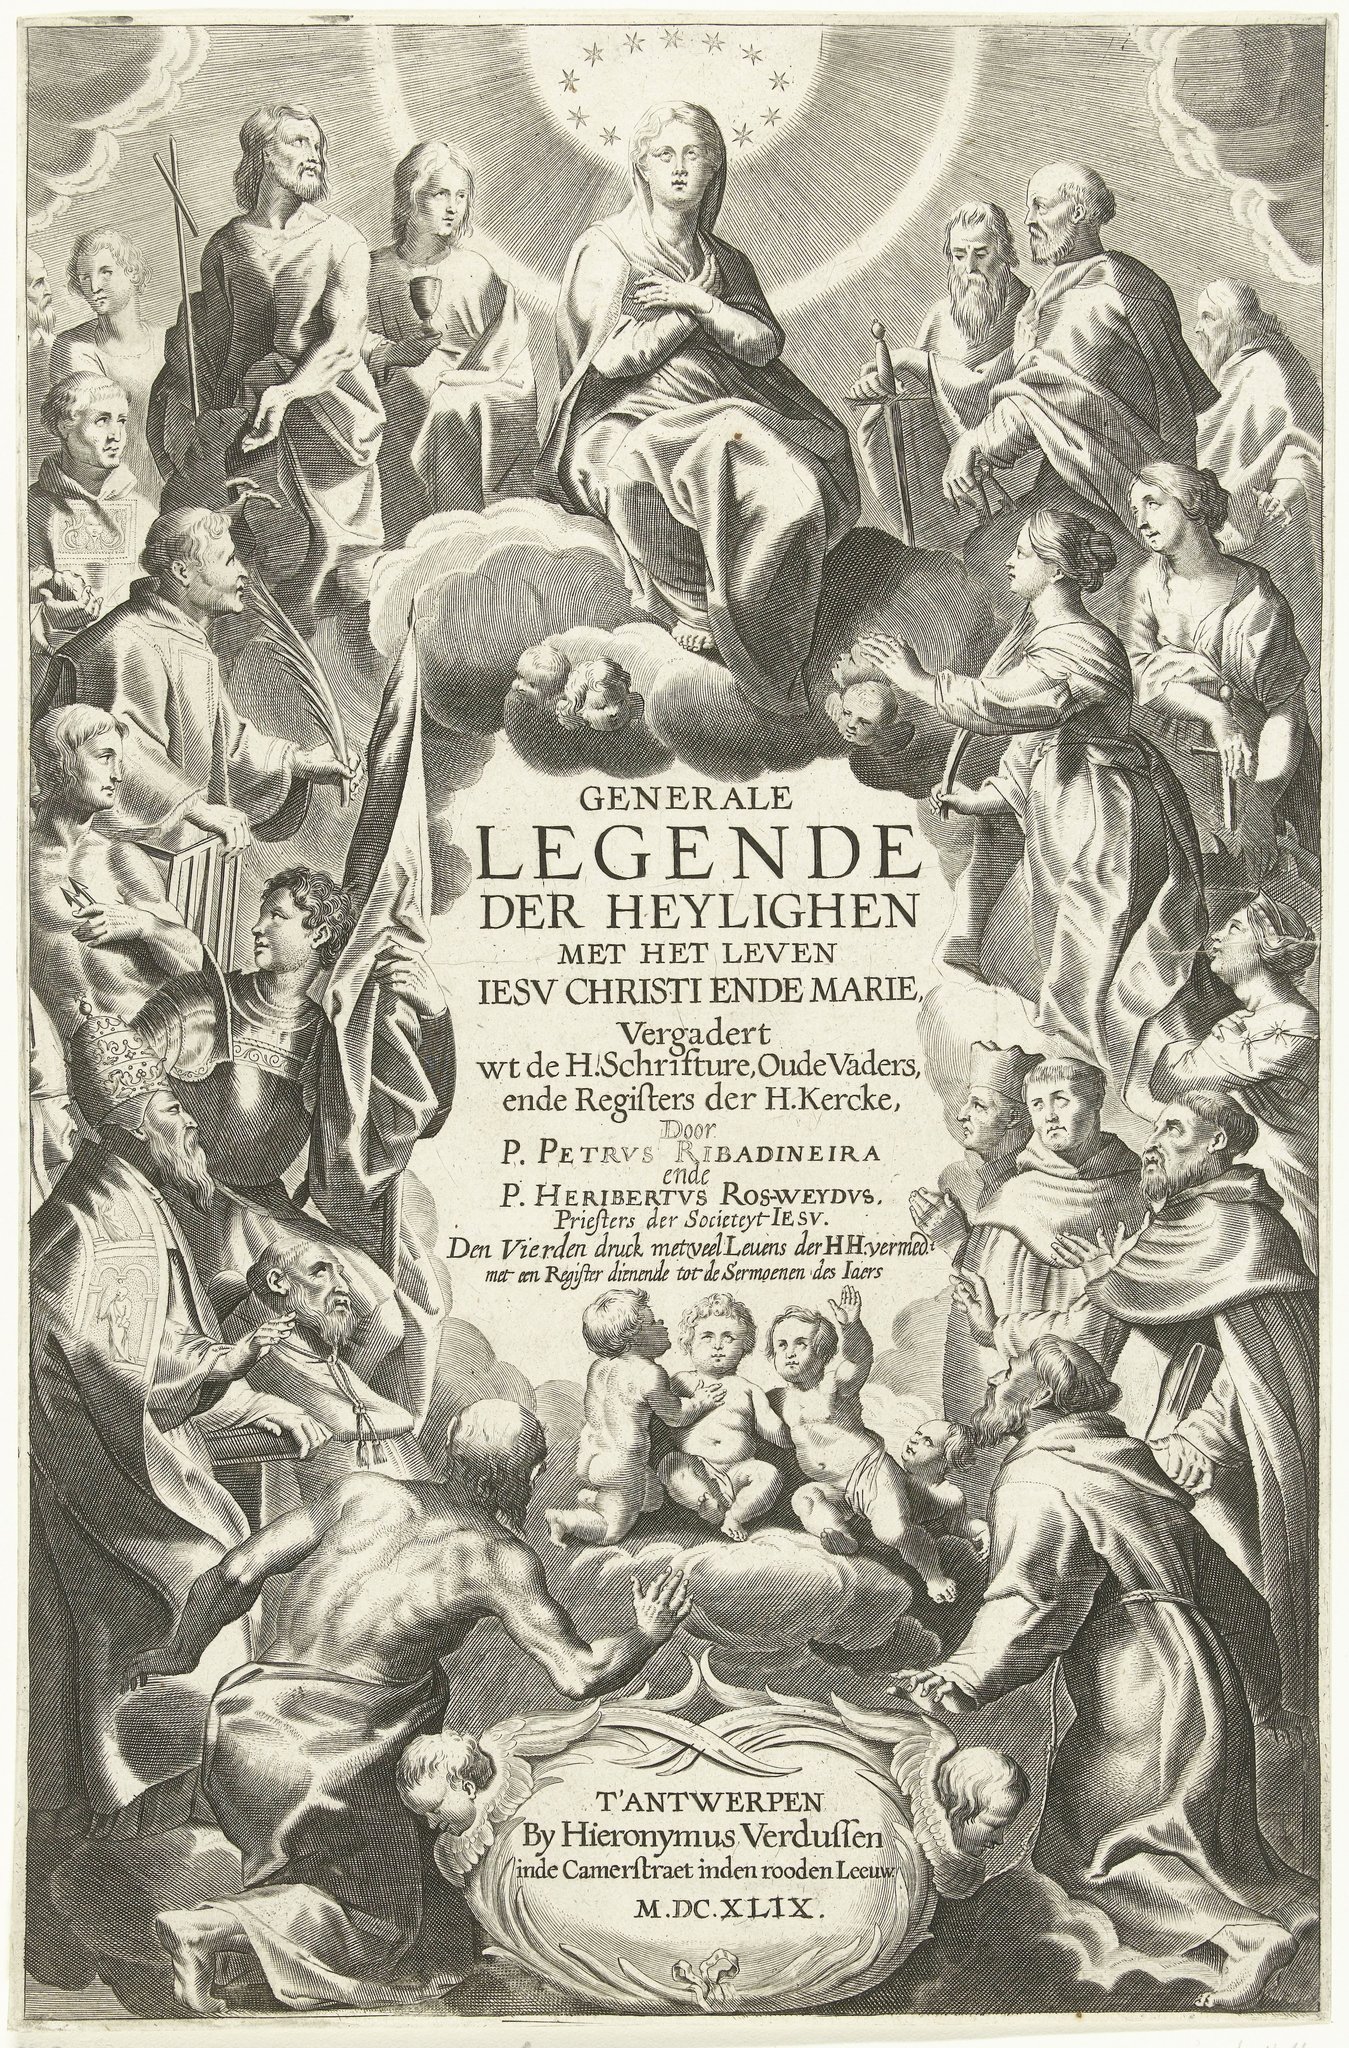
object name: titelblad, titelpagina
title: Titelpagina voor: P. de Ribadenetra en H. Rosweyde, Generale Legende der Heylighen, 1649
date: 1649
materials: paper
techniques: engraving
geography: antwerp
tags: madonna accompanied by saint(s), title-page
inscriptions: collector's mark: Lugt 240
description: Bovenaan in het midden zit Maria op de wolken, de armen gevouwen voor de borst. Links en rechts van haar mannelijke en vrouwelijk heiligen en kerkelijke functionarissen die naar haar opkijken.